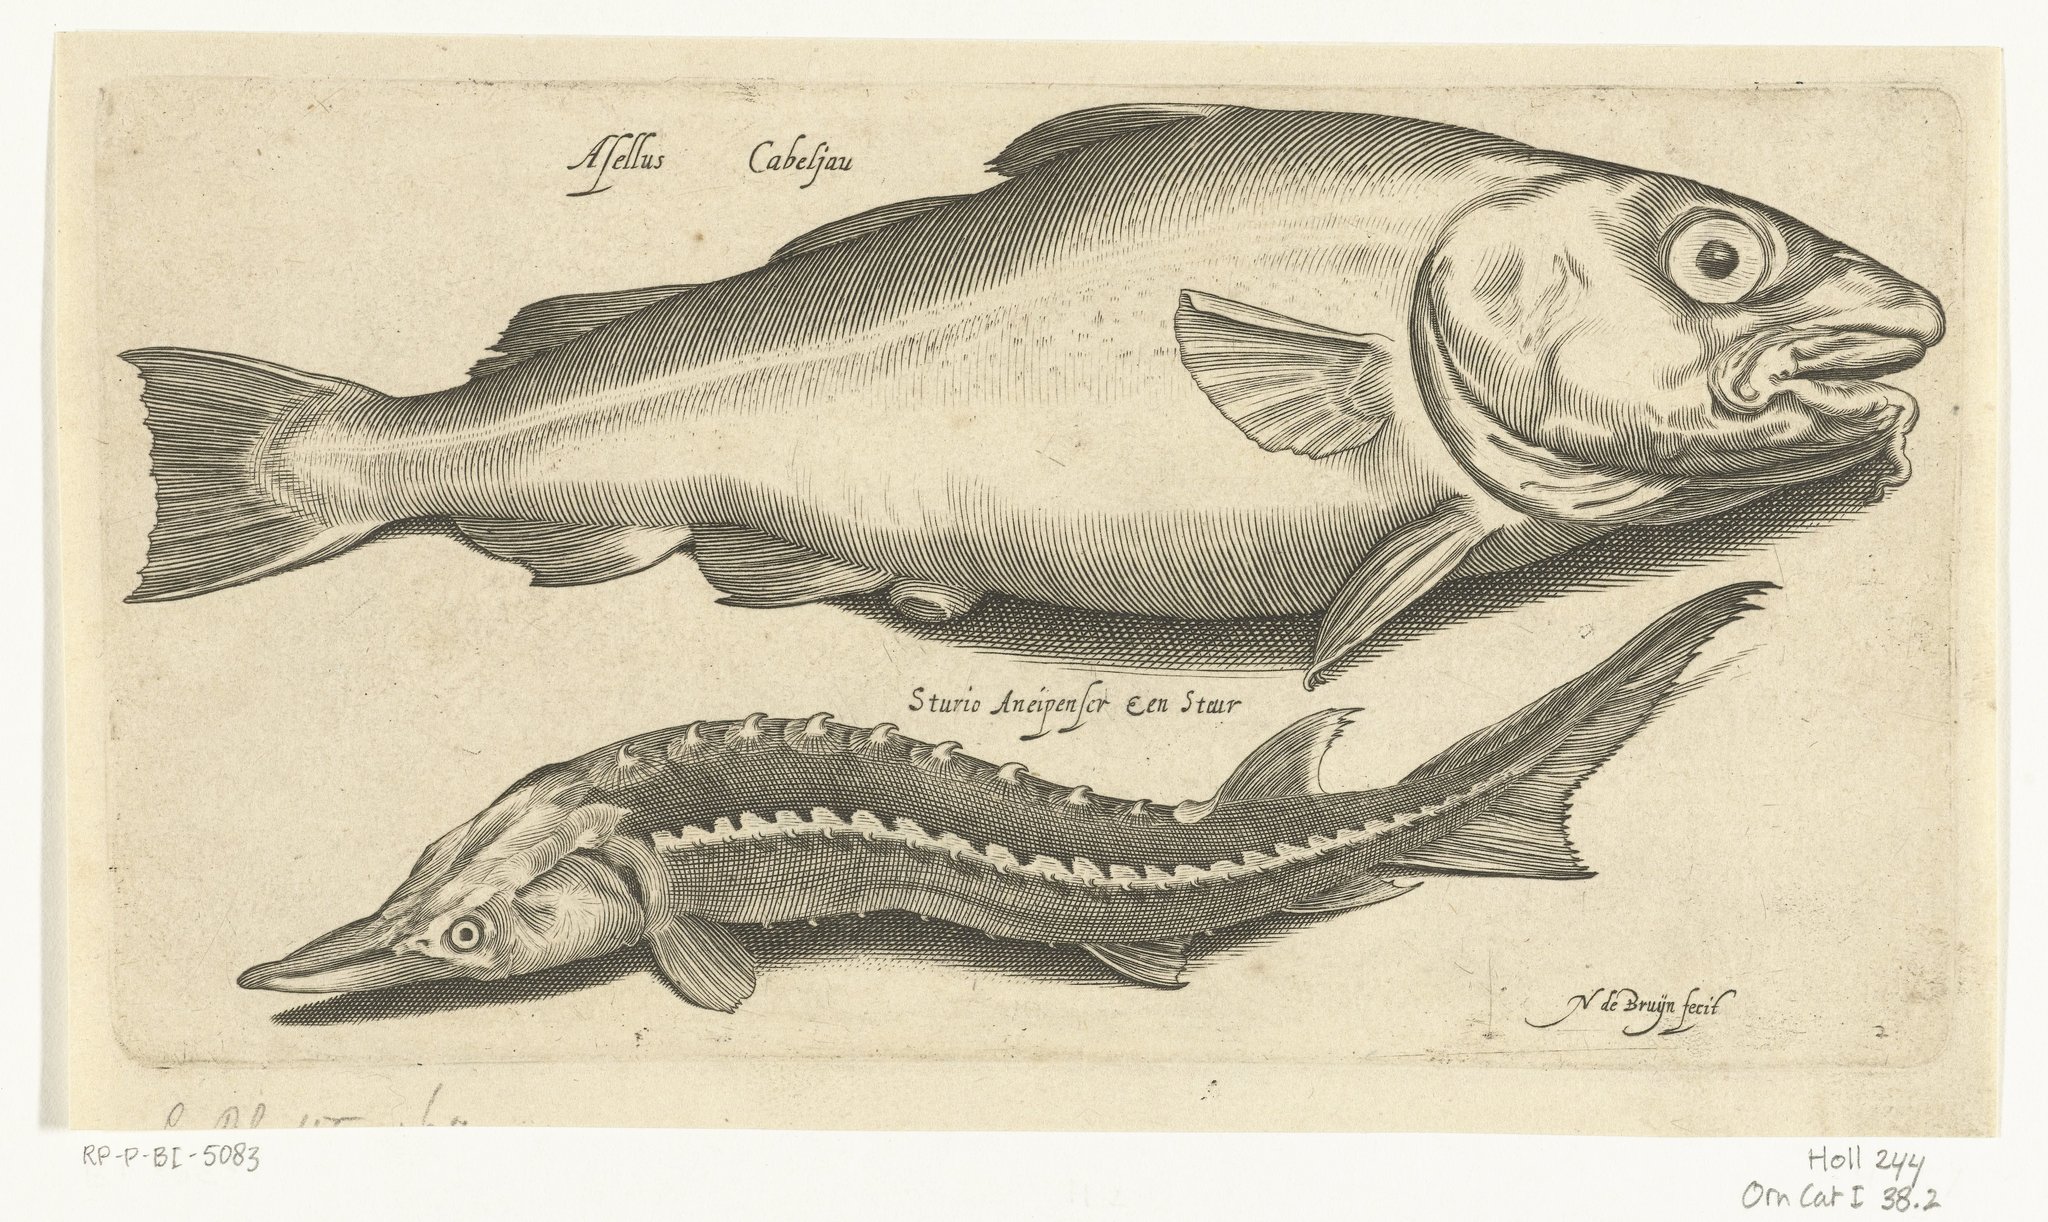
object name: print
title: Libelivs varia Genera piscium complectens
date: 1581-1656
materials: paper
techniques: engraving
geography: netherlands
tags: fishes, bony fishes: sturgeon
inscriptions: collector's mark: Lugt 2228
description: Prent uit serie Libelivs varia Genera piscium complectens van dertien prenten met zoetwatervissen, zeevissen, kikkers, schaaldieren en zeewezens (inclusief titelprent). Vermoedelijk ging een uitgave van Assuerus van Londerseel vooraf aan deze editie van Francoys van Beusekom, zie De Groot 1988, p. 38.